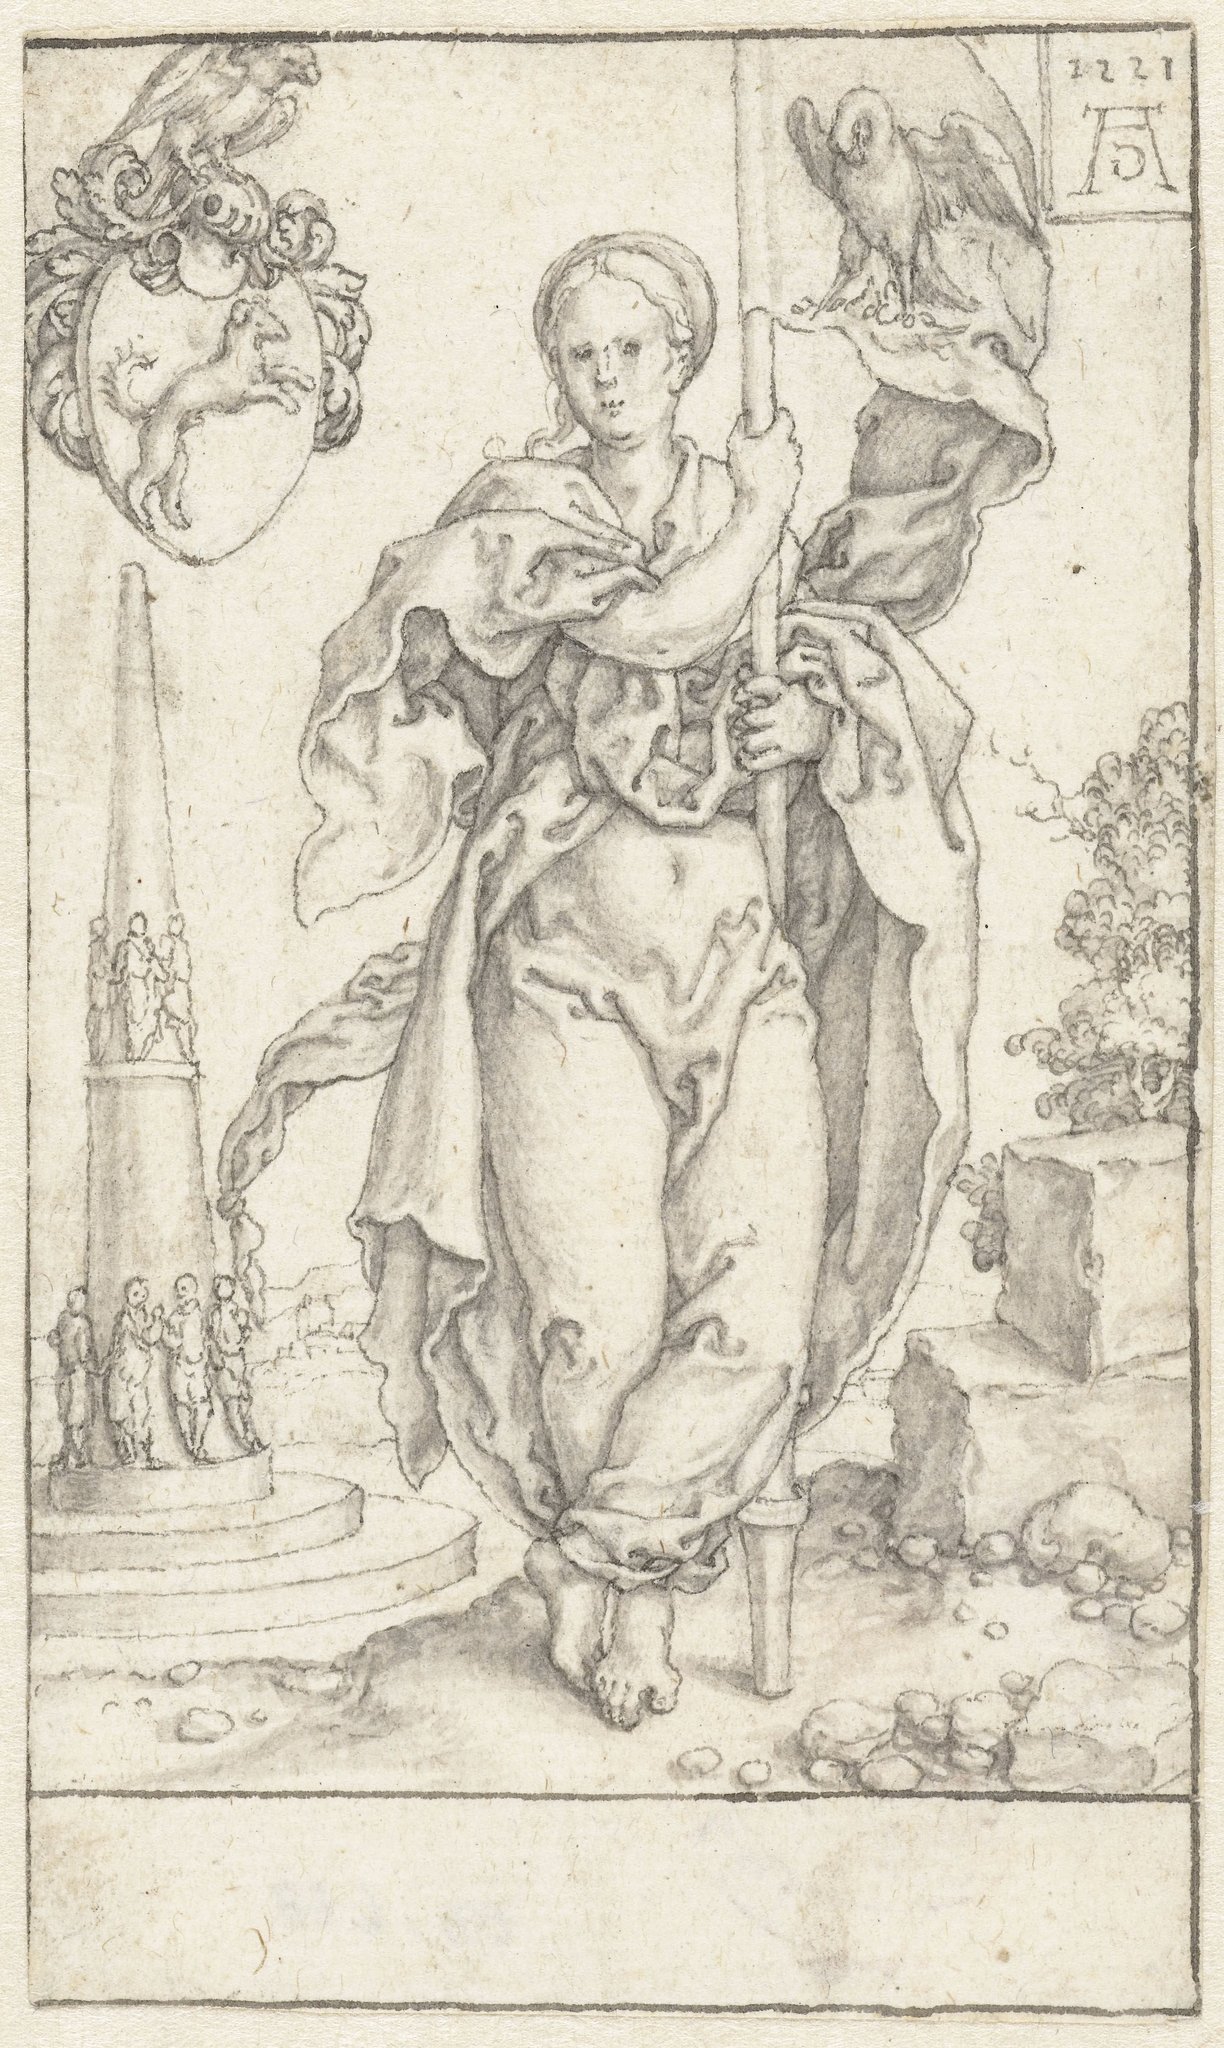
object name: drawing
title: Naastenliefde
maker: heinrich aldegrever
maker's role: draughtsman, print maker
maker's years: 1502-1561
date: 1551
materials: ink, paper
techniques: brush, pen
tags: charity, 'caritas'; 'carità' (ripa) ~ one of the three theological virtues